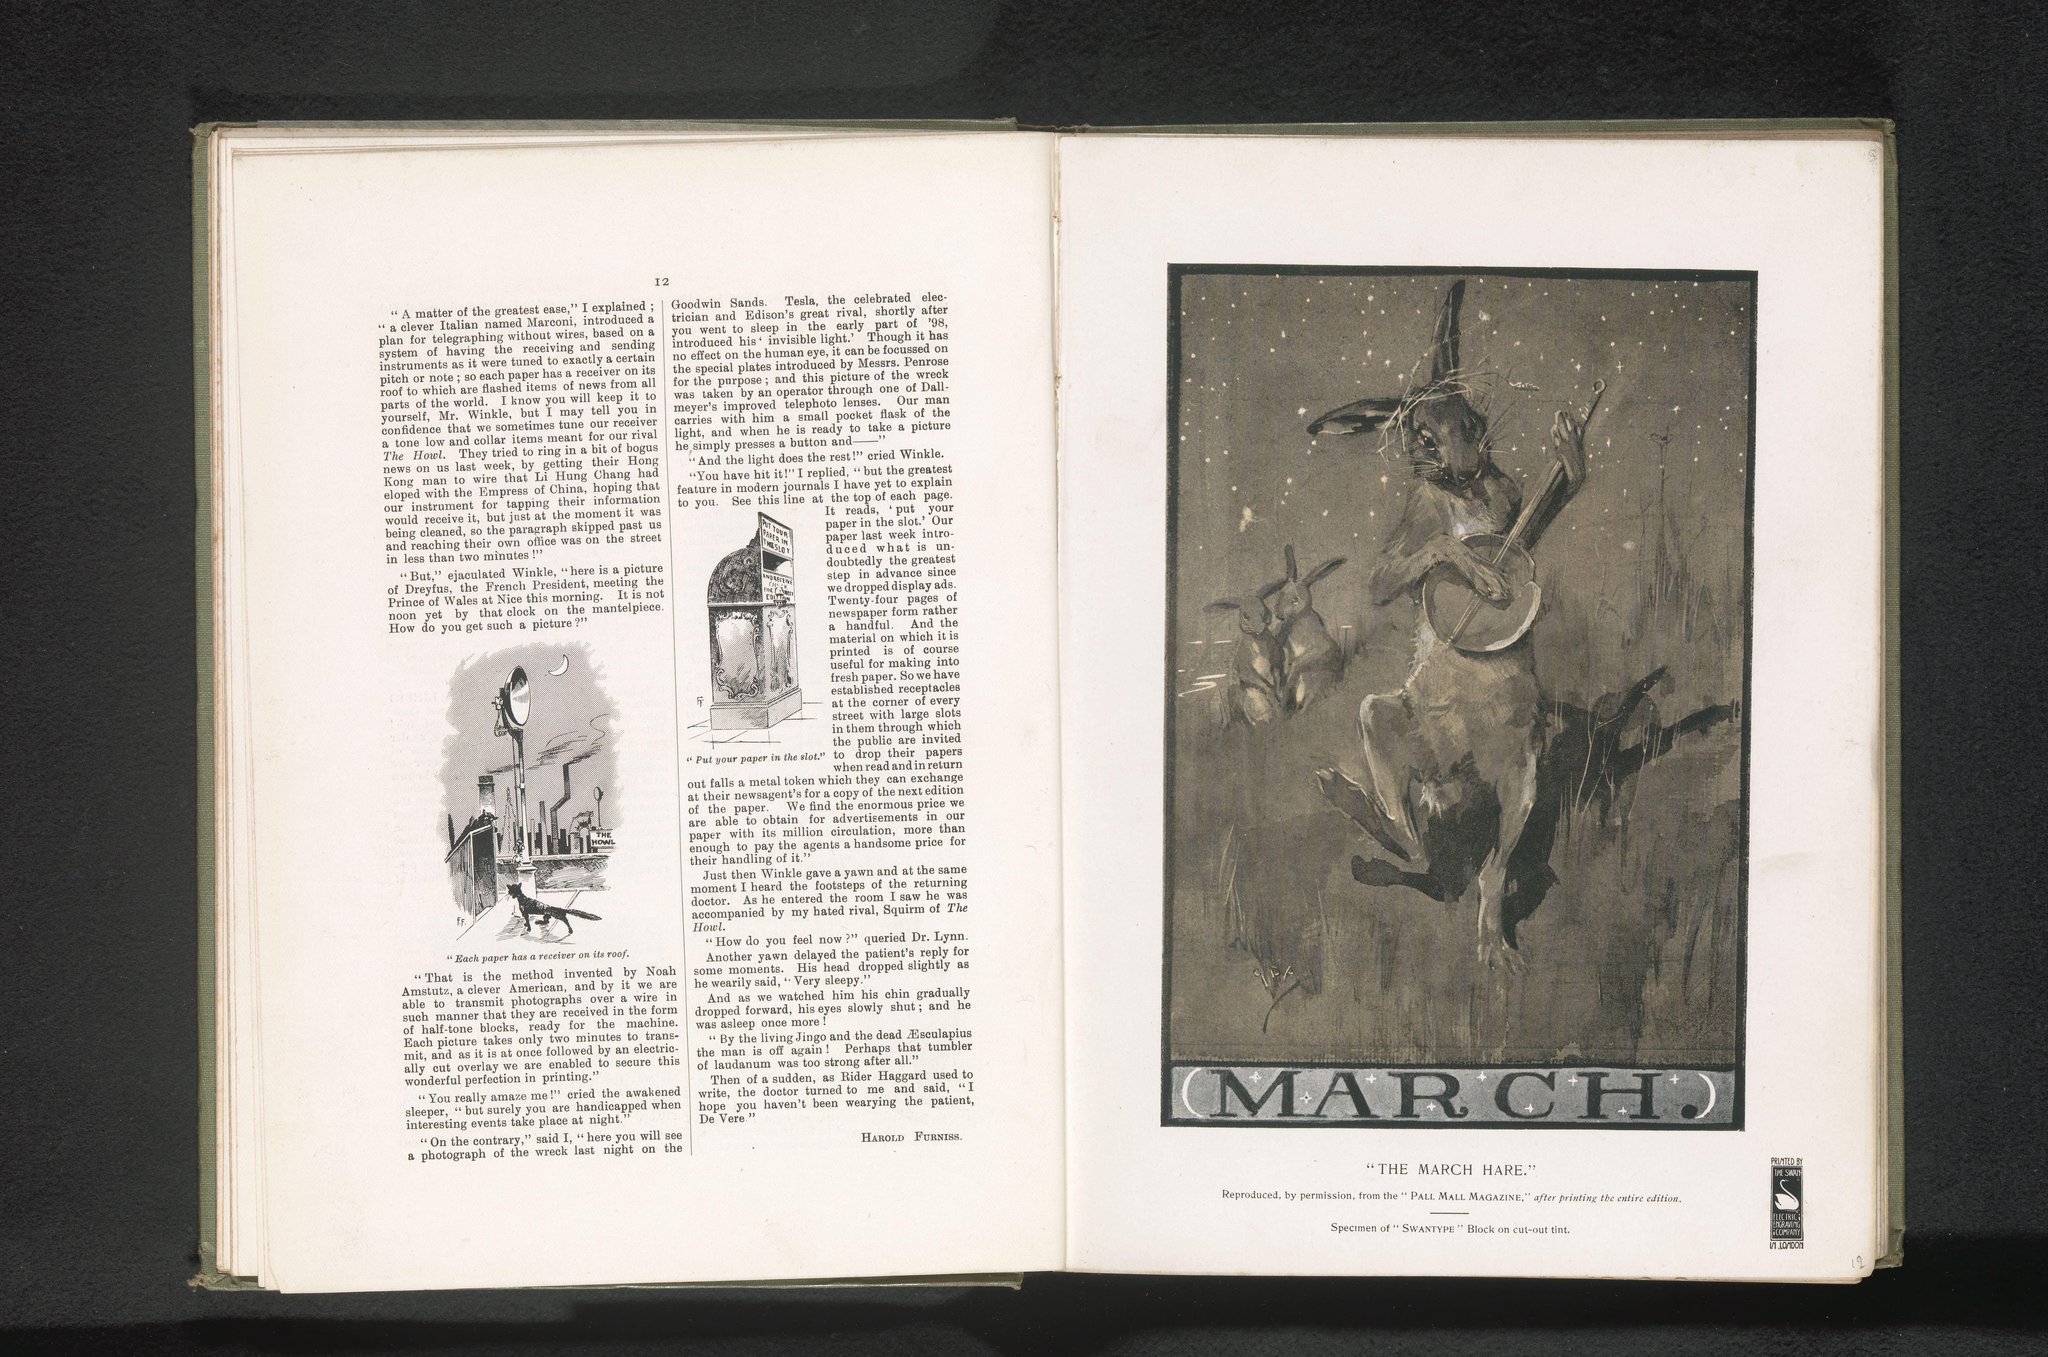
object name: reproduction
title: Reproductie van een tekening van een haas die banjo speelt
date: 1893-1898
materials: paper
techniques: autotype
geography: london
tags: rodents: hare